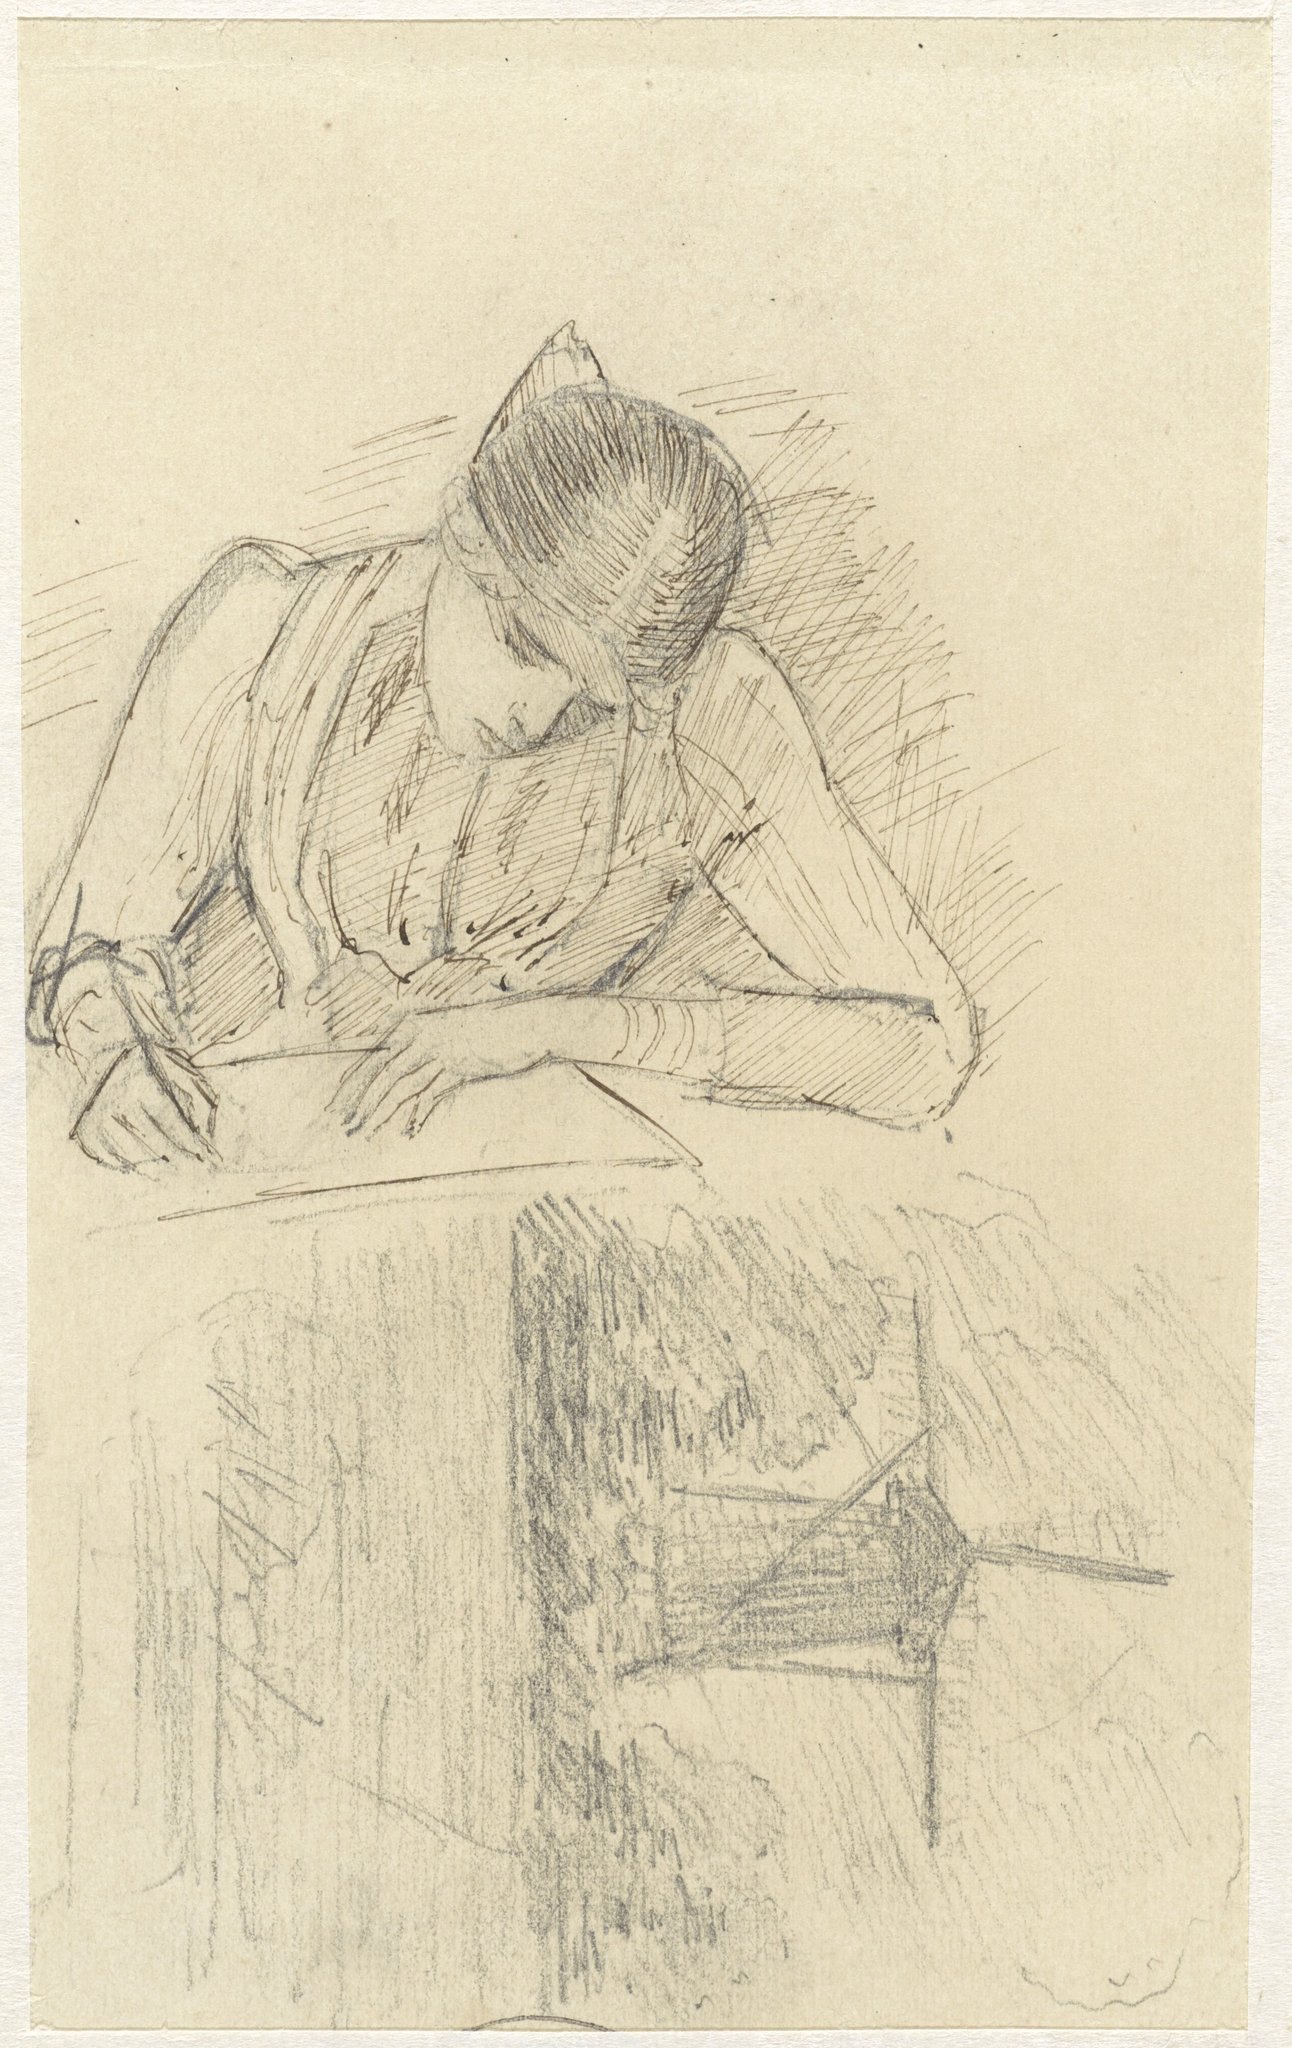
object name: drawing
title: Schrijvende vrouw en molen aan het water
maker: jozef israëls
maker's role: draughtsman, painter, print maker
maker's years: 1824-1911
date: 1834-1911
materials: chalk, ink, paper, pencil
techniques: pen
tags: handwriting, writing as activity, windmill